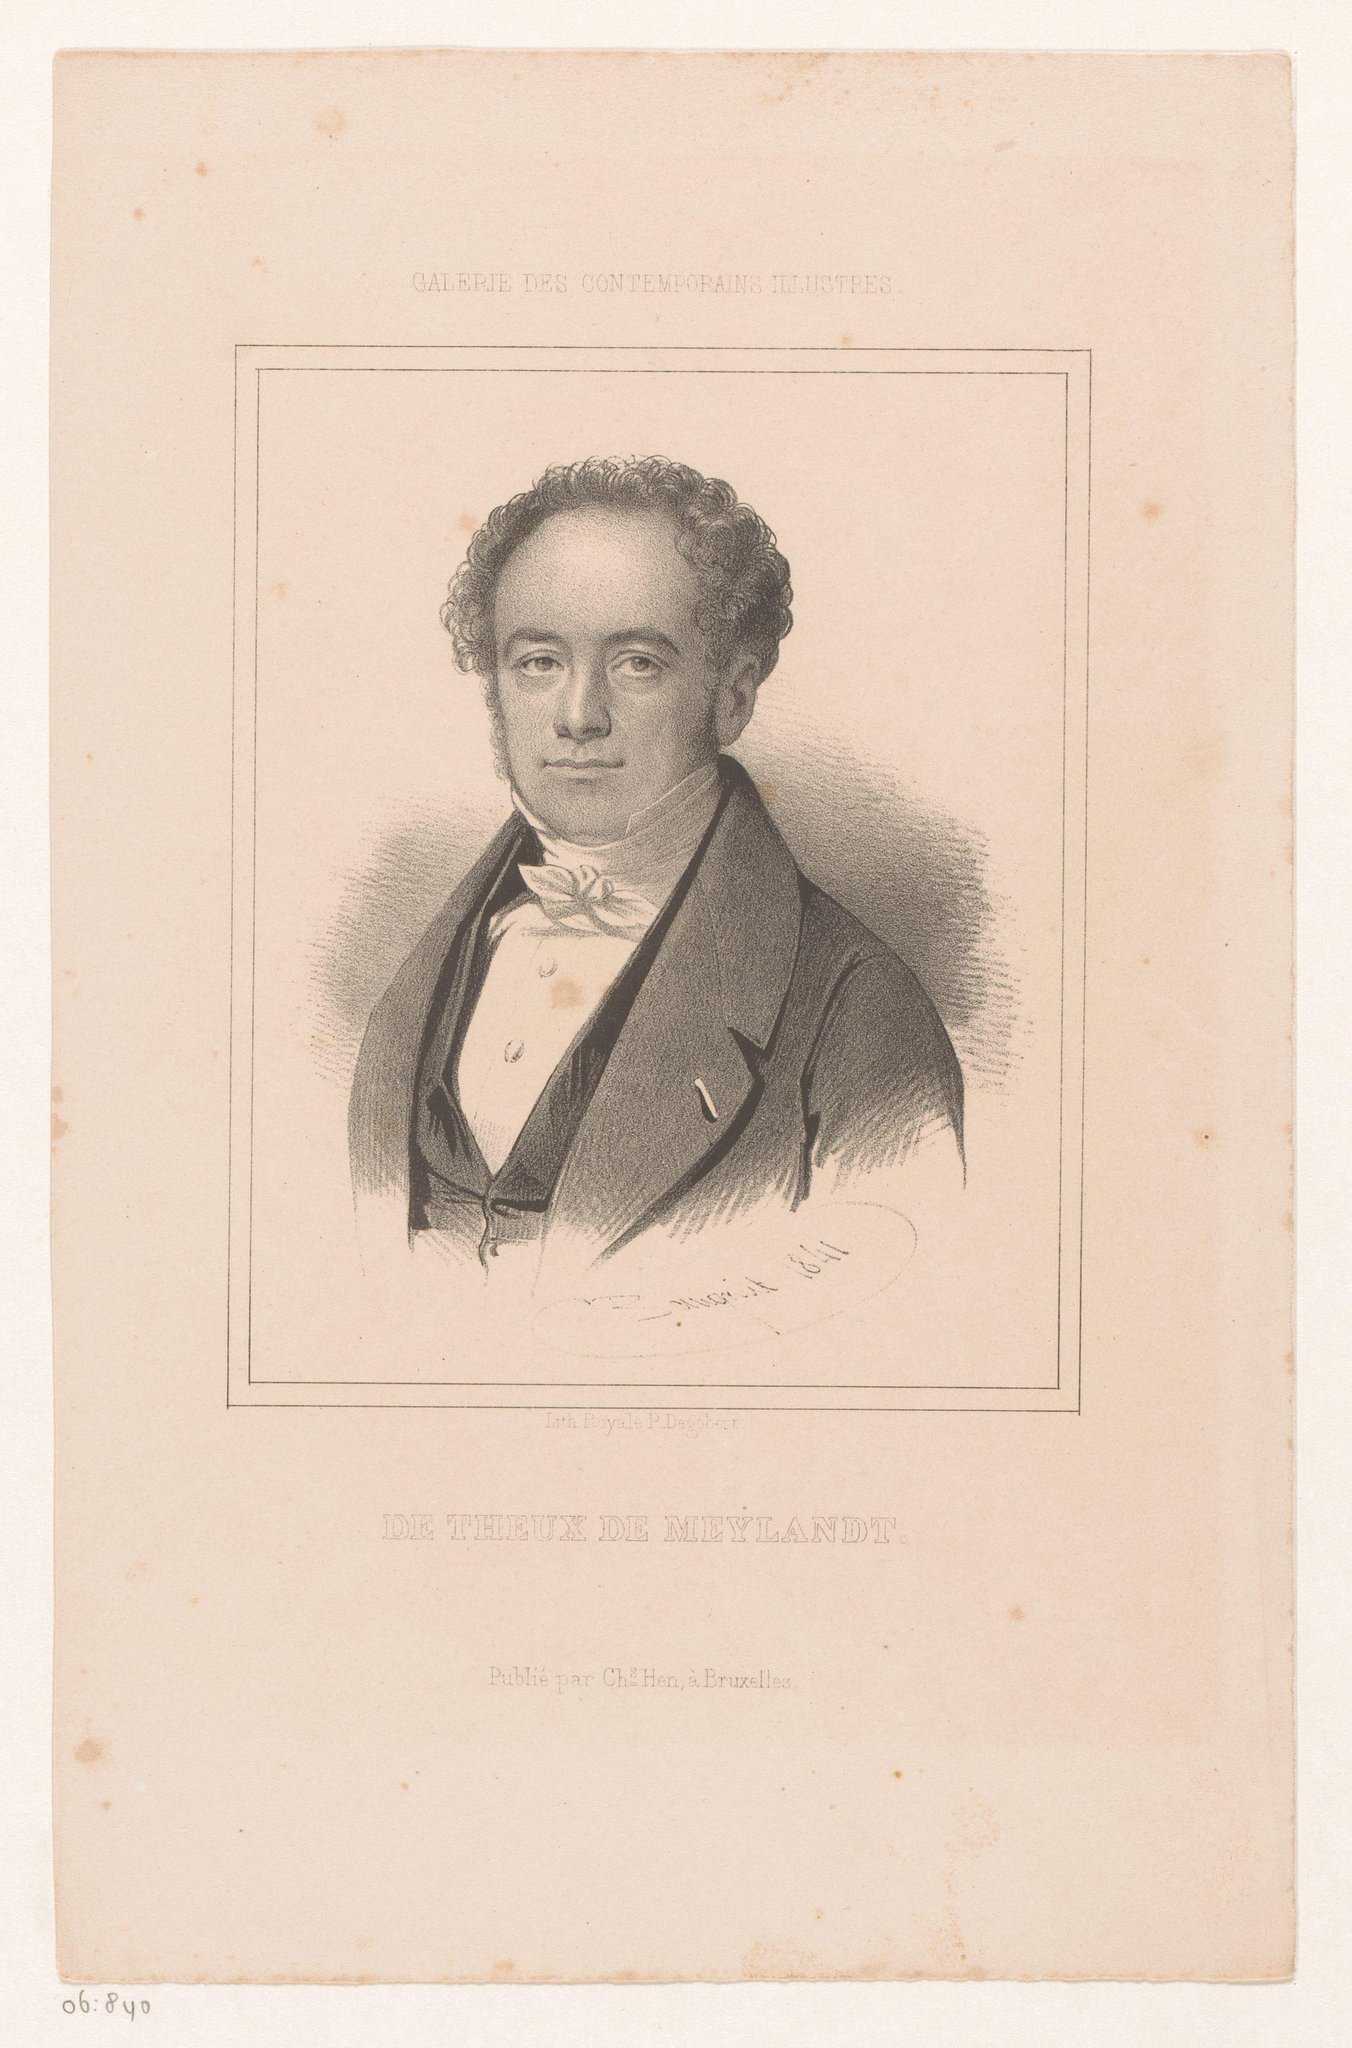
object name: print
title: De Theux de Meylandt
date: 1841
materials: paper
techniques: lithograph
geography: brussels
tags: sint-truiden, adult man, historical persons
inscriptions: collector's mark: Lugt 2228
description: Prent uit: Galerie des contemporains illustres. Brussel: Ch. Hen, 1841.